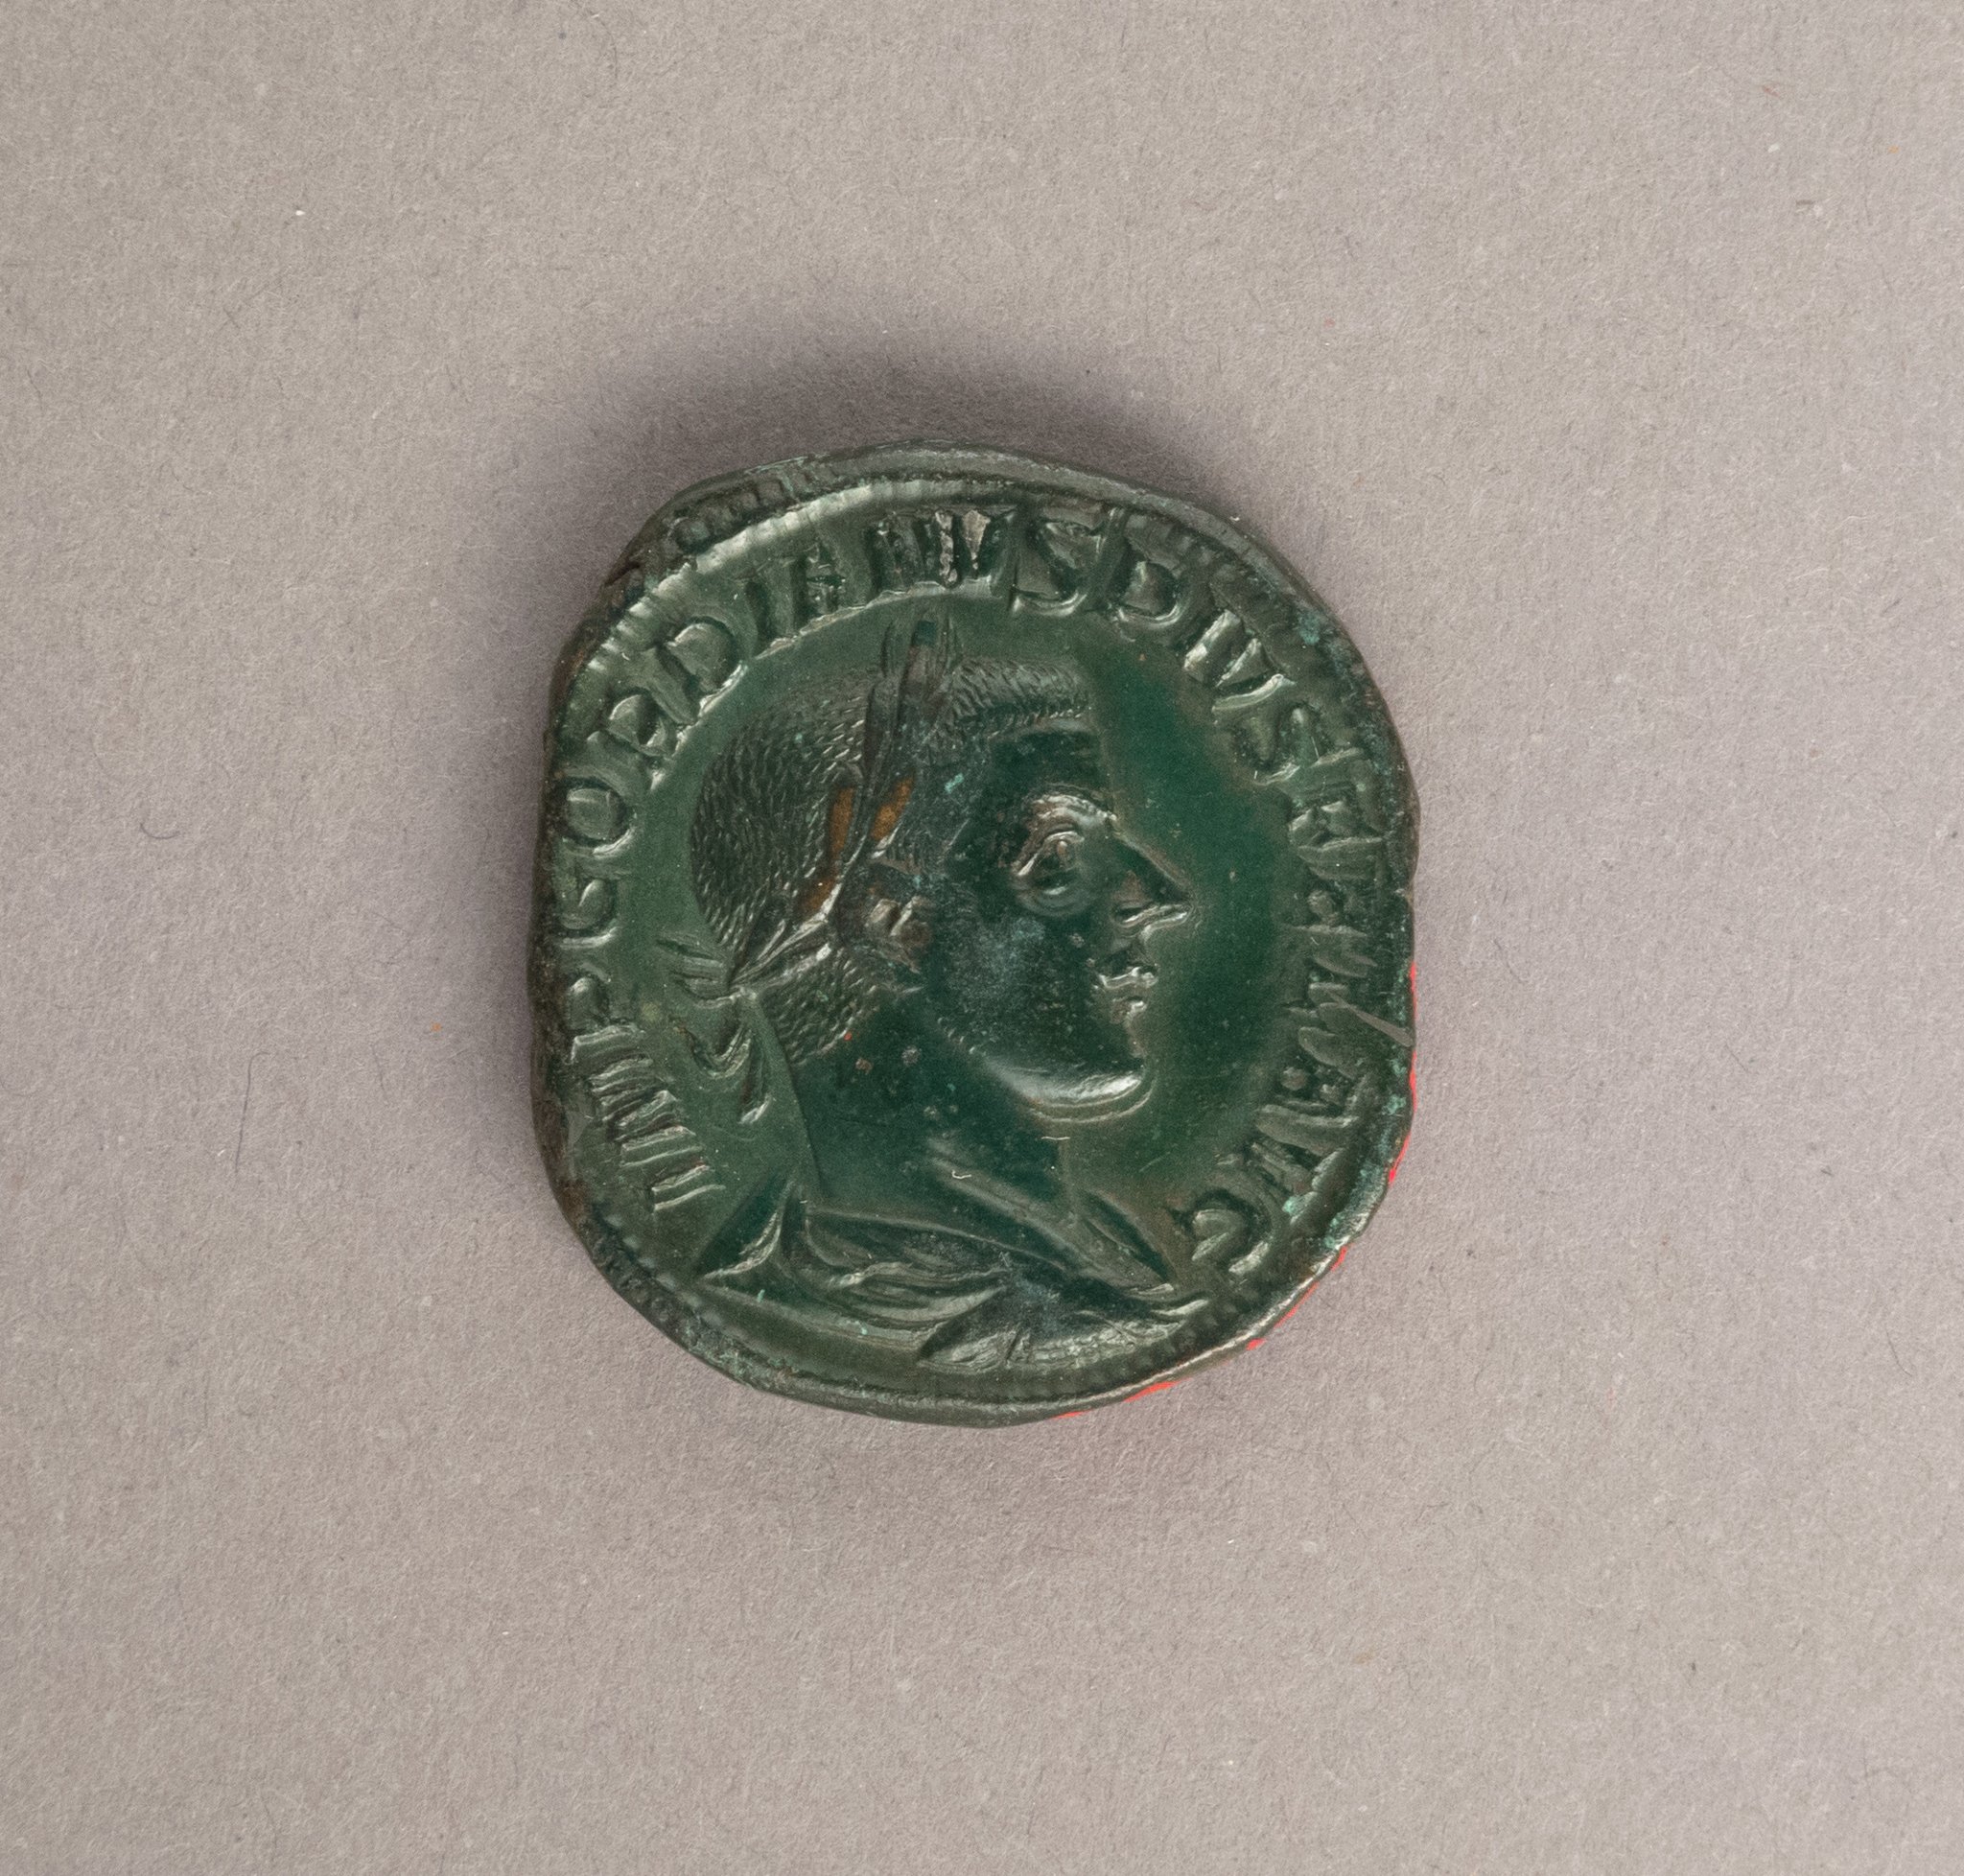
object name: sestertius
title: Bronze sestertius of Gordian III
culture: roman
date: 240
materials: bronze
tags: men,profiles